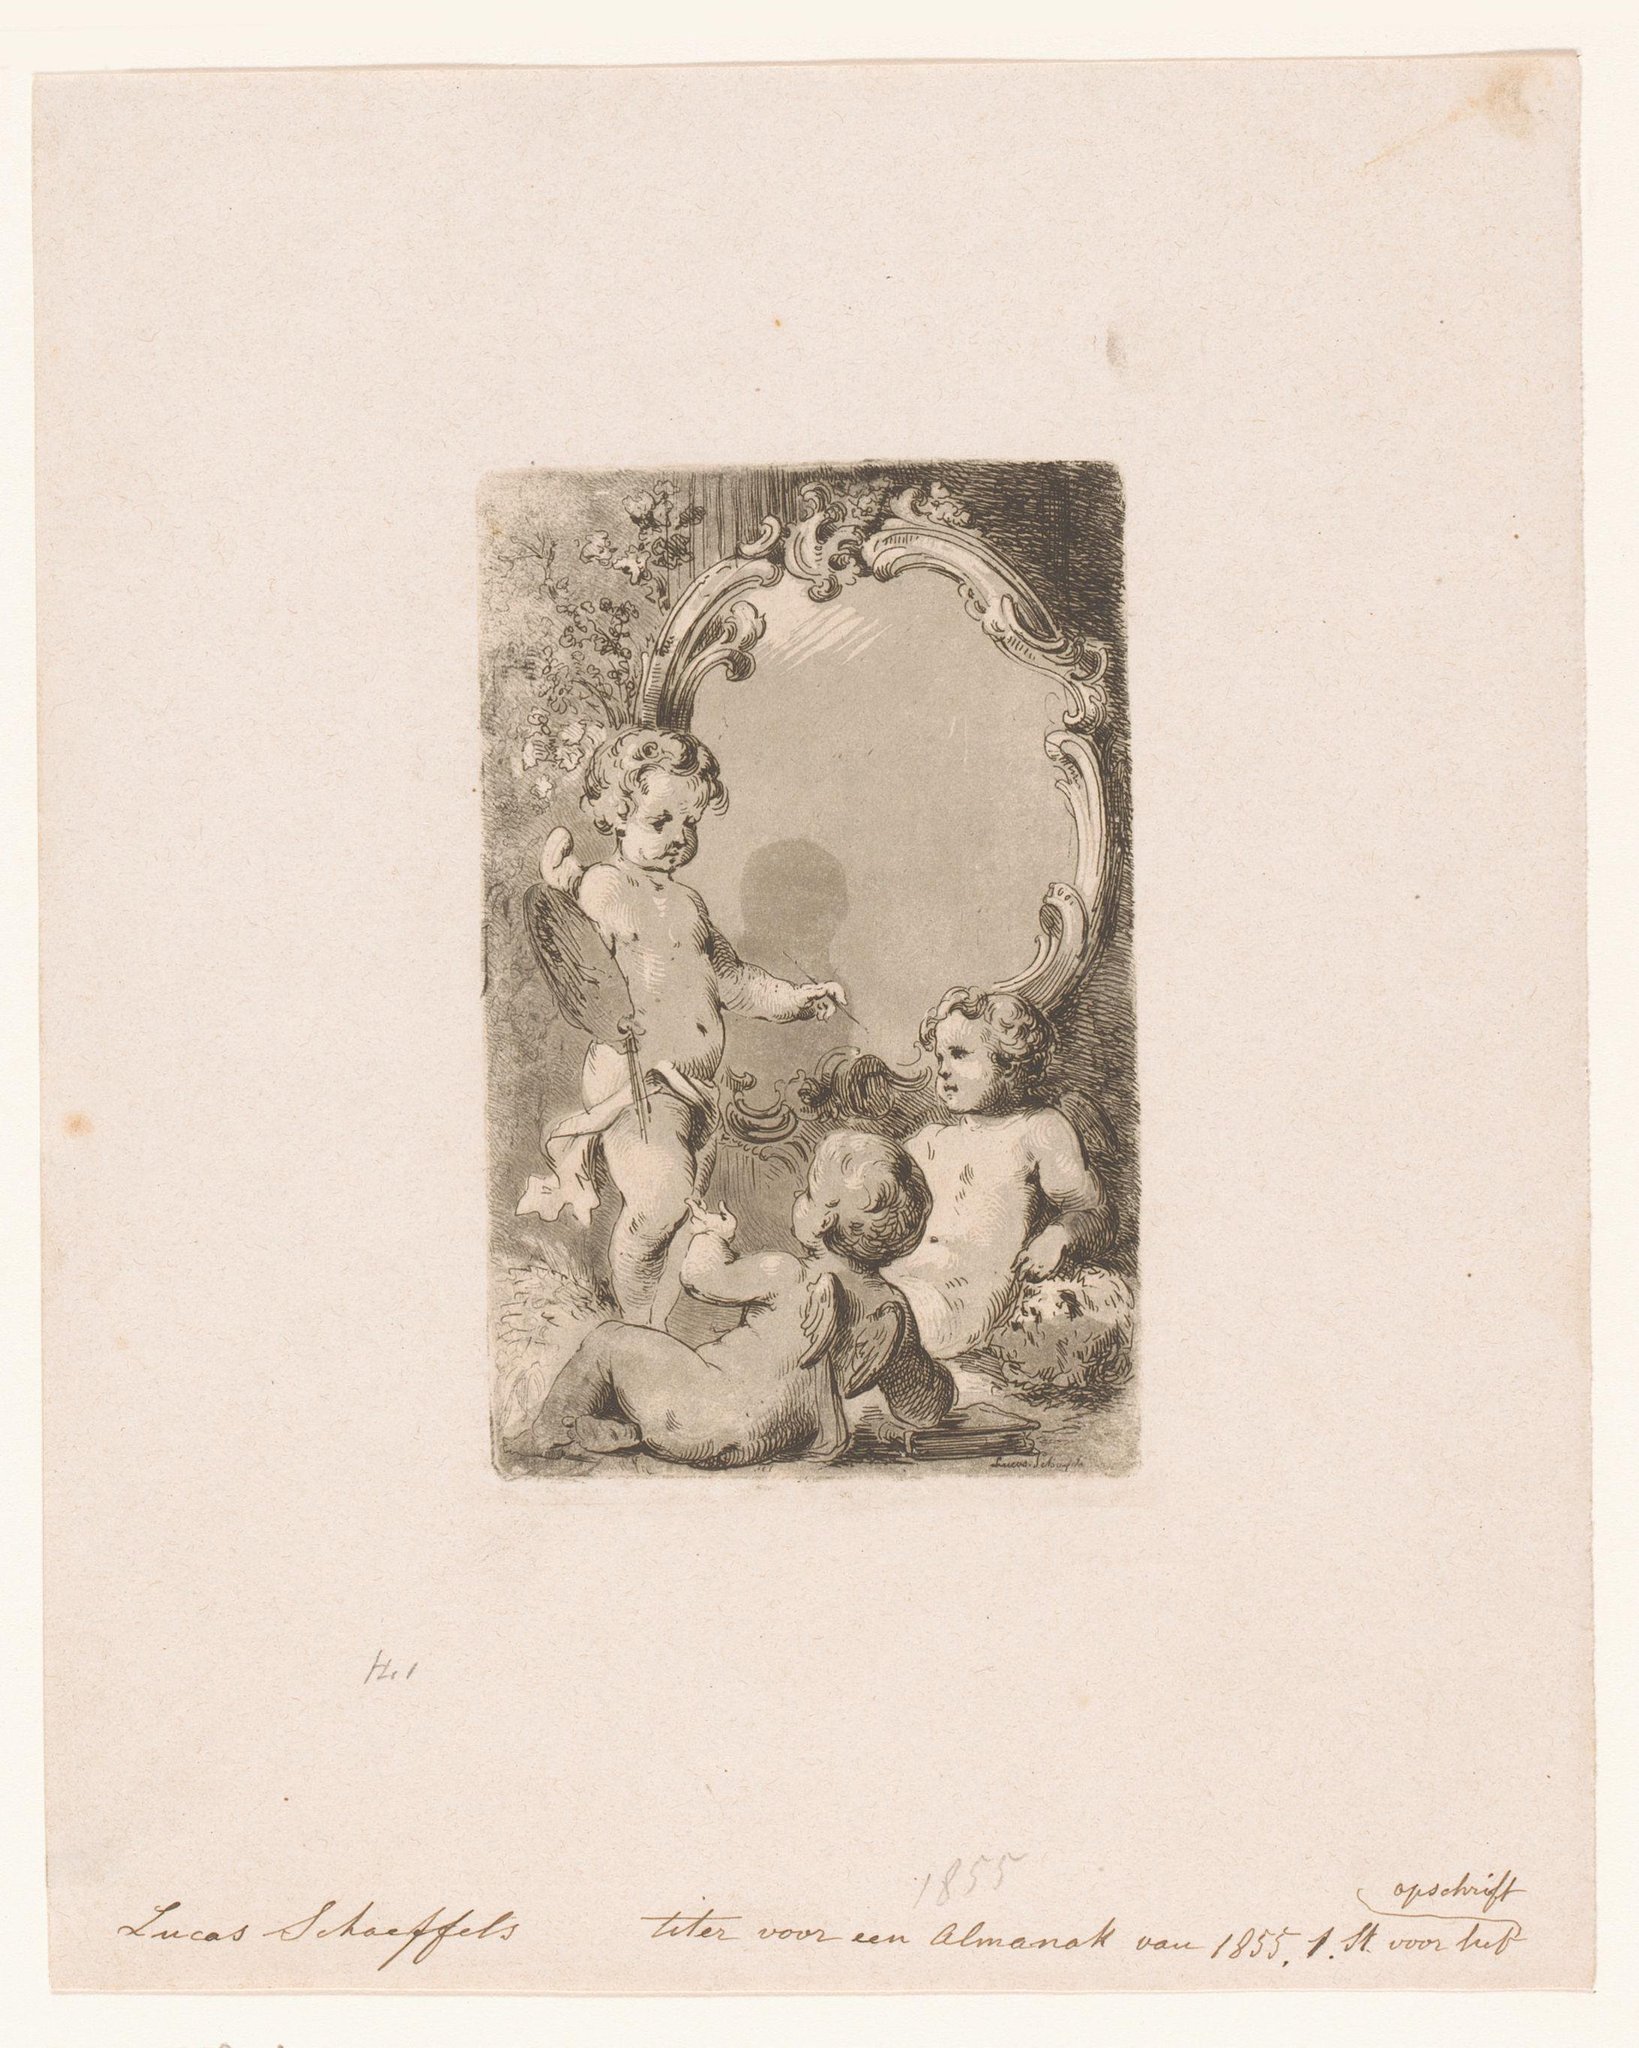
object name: print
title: Drie putti bij een ornamenteel cartouche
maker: lucas victor schaefels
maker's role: draughtsman, print maker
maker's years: 1824-1885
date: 1853-1855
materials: paper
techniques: aquatint, etching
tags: 'pictura', symbolic representations, allegories and emblems ~ painting; 'pittura' (ripa), 'sculptura', symbolic representations, allegories and emblems ~ sculpture; 'scoltura' (ripa), 'architectura', symbolic representations, allegories and emblems ~ architecture; 'architettura' (ripa), cupids: 'amores', 'amoretti', 'putti'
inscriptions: collector's mark: Lugt 2228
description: Latere staat is de titelpagina voor: Almanak der St.-Lukas Gilde voor het jaar 1854 & 1855. Antwerpen: Gebroeders Peeters, 1855.